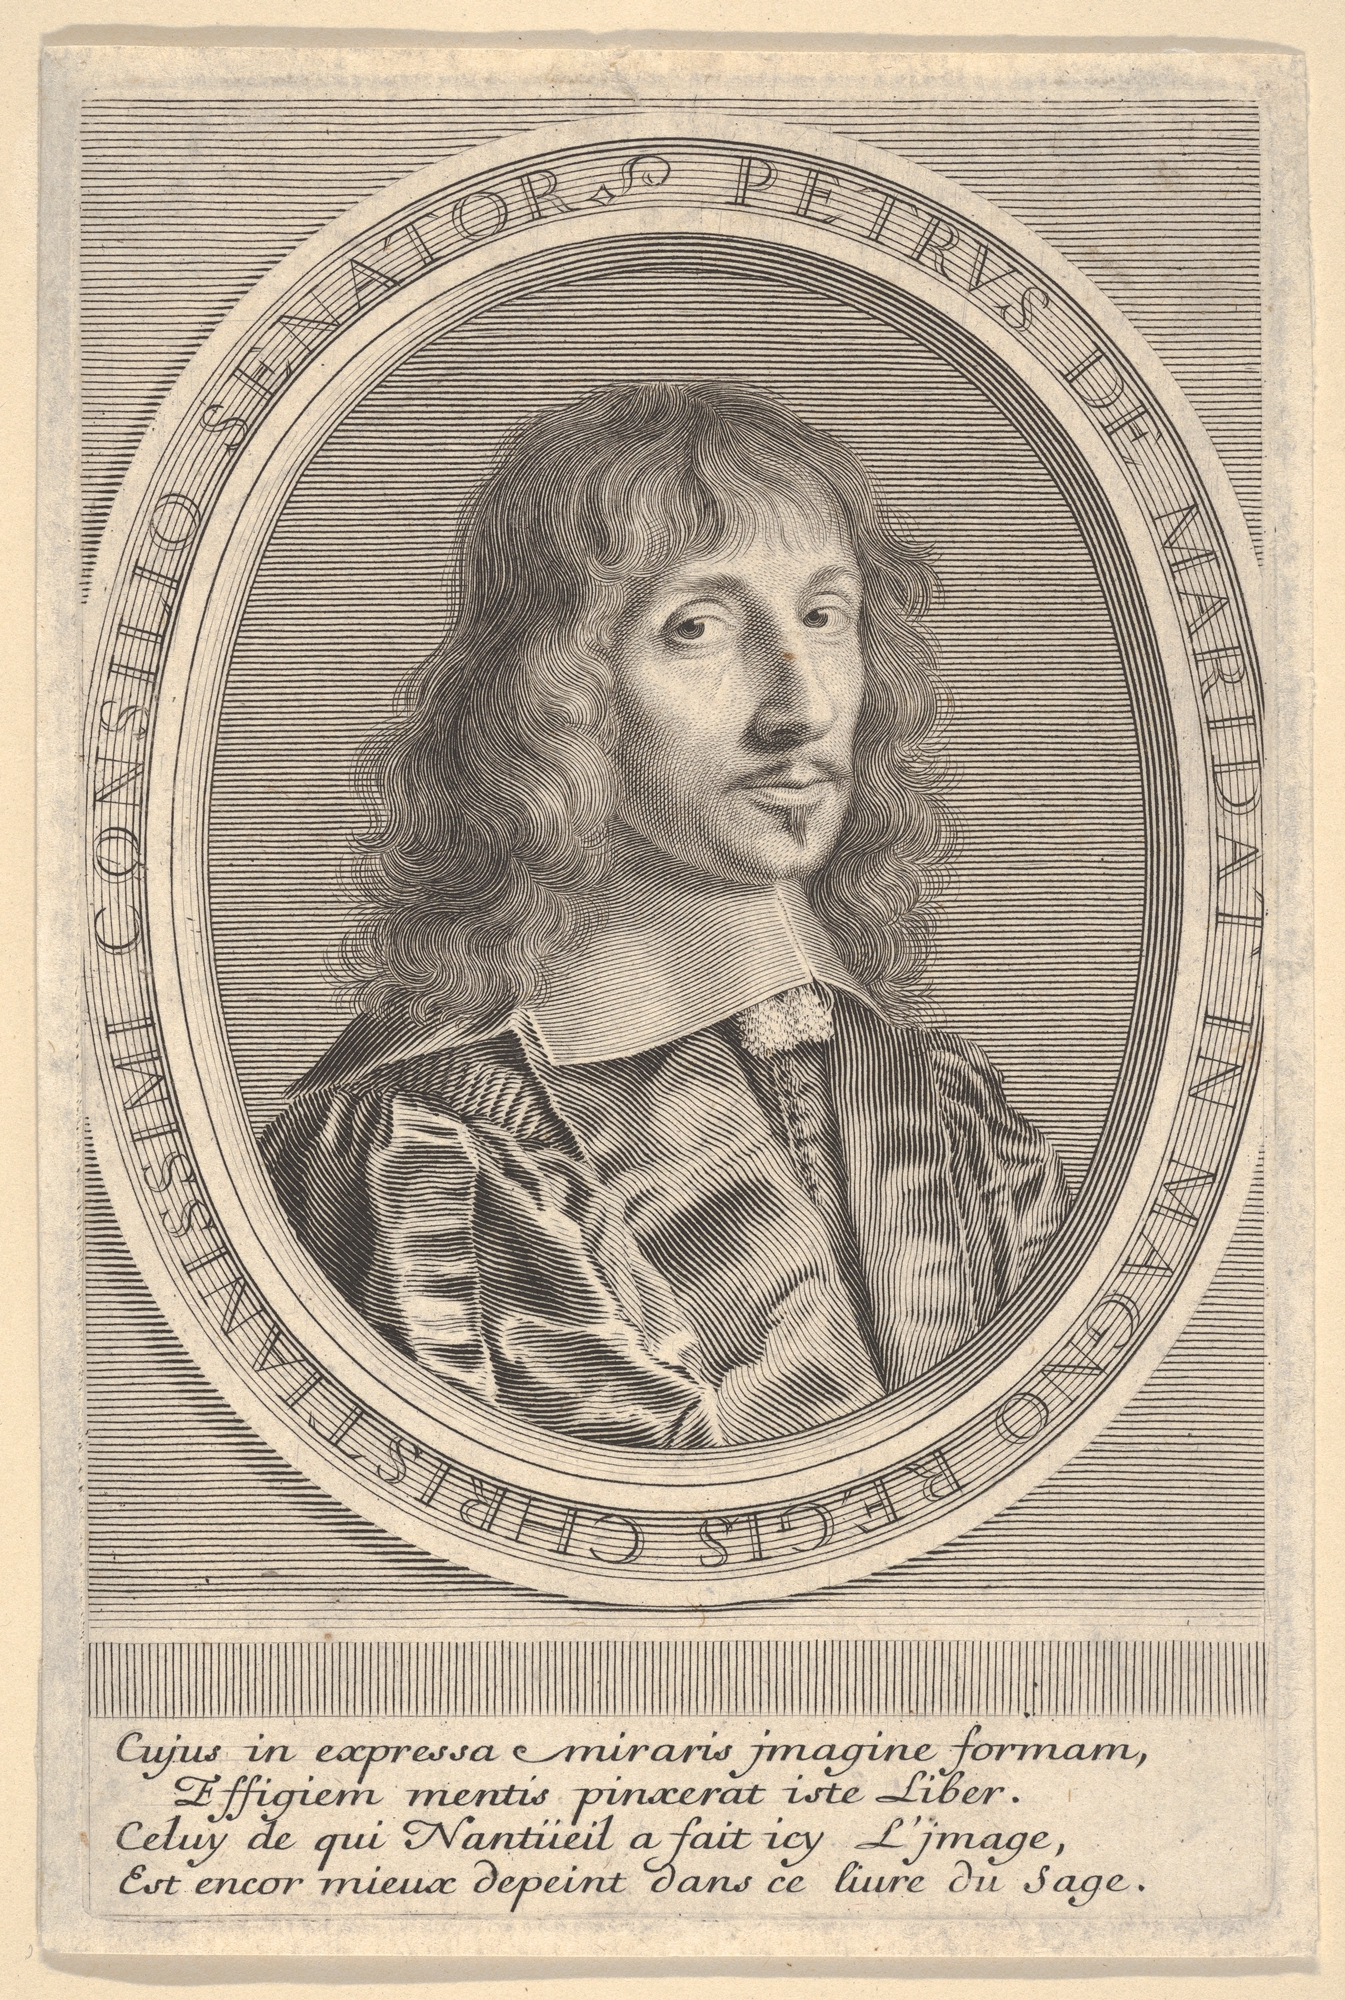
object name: print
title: Pierre da Maridat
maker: robert nanteuil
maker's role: artist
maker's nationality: french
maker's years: 1623-1678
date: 1653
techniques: engraving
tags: men,portraits